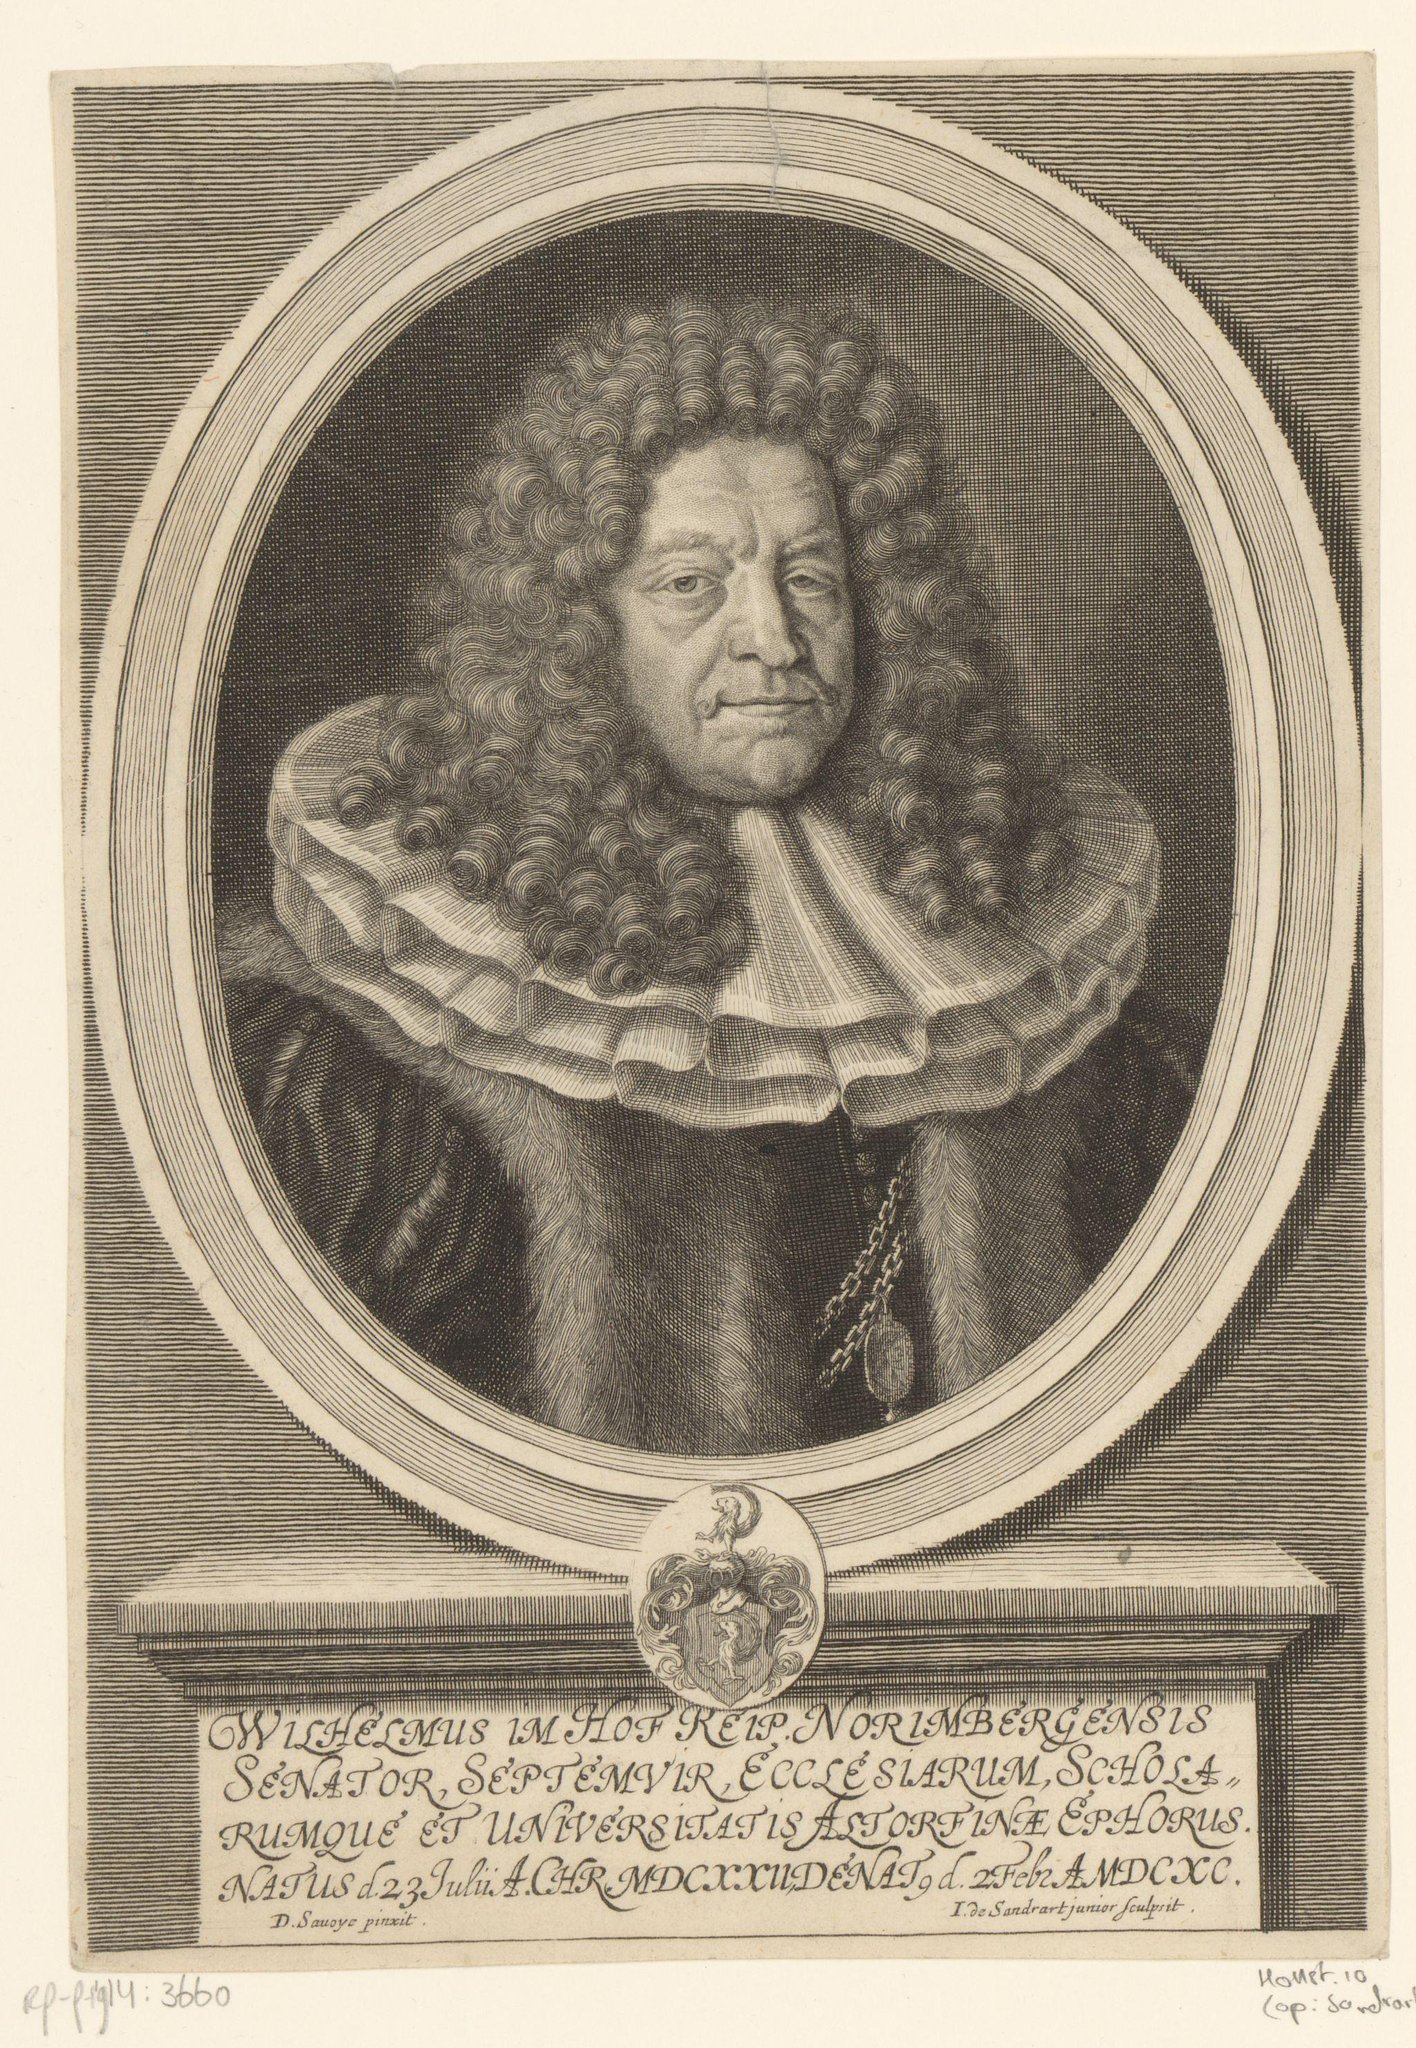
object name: print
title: Portret van Wilhelm III Imhof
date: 1690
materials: paper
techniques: engraving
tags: historical persons, pendant, trinket, 'breloque', armorial bearing, heraldry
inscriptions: collector's mark: Lugt 2228